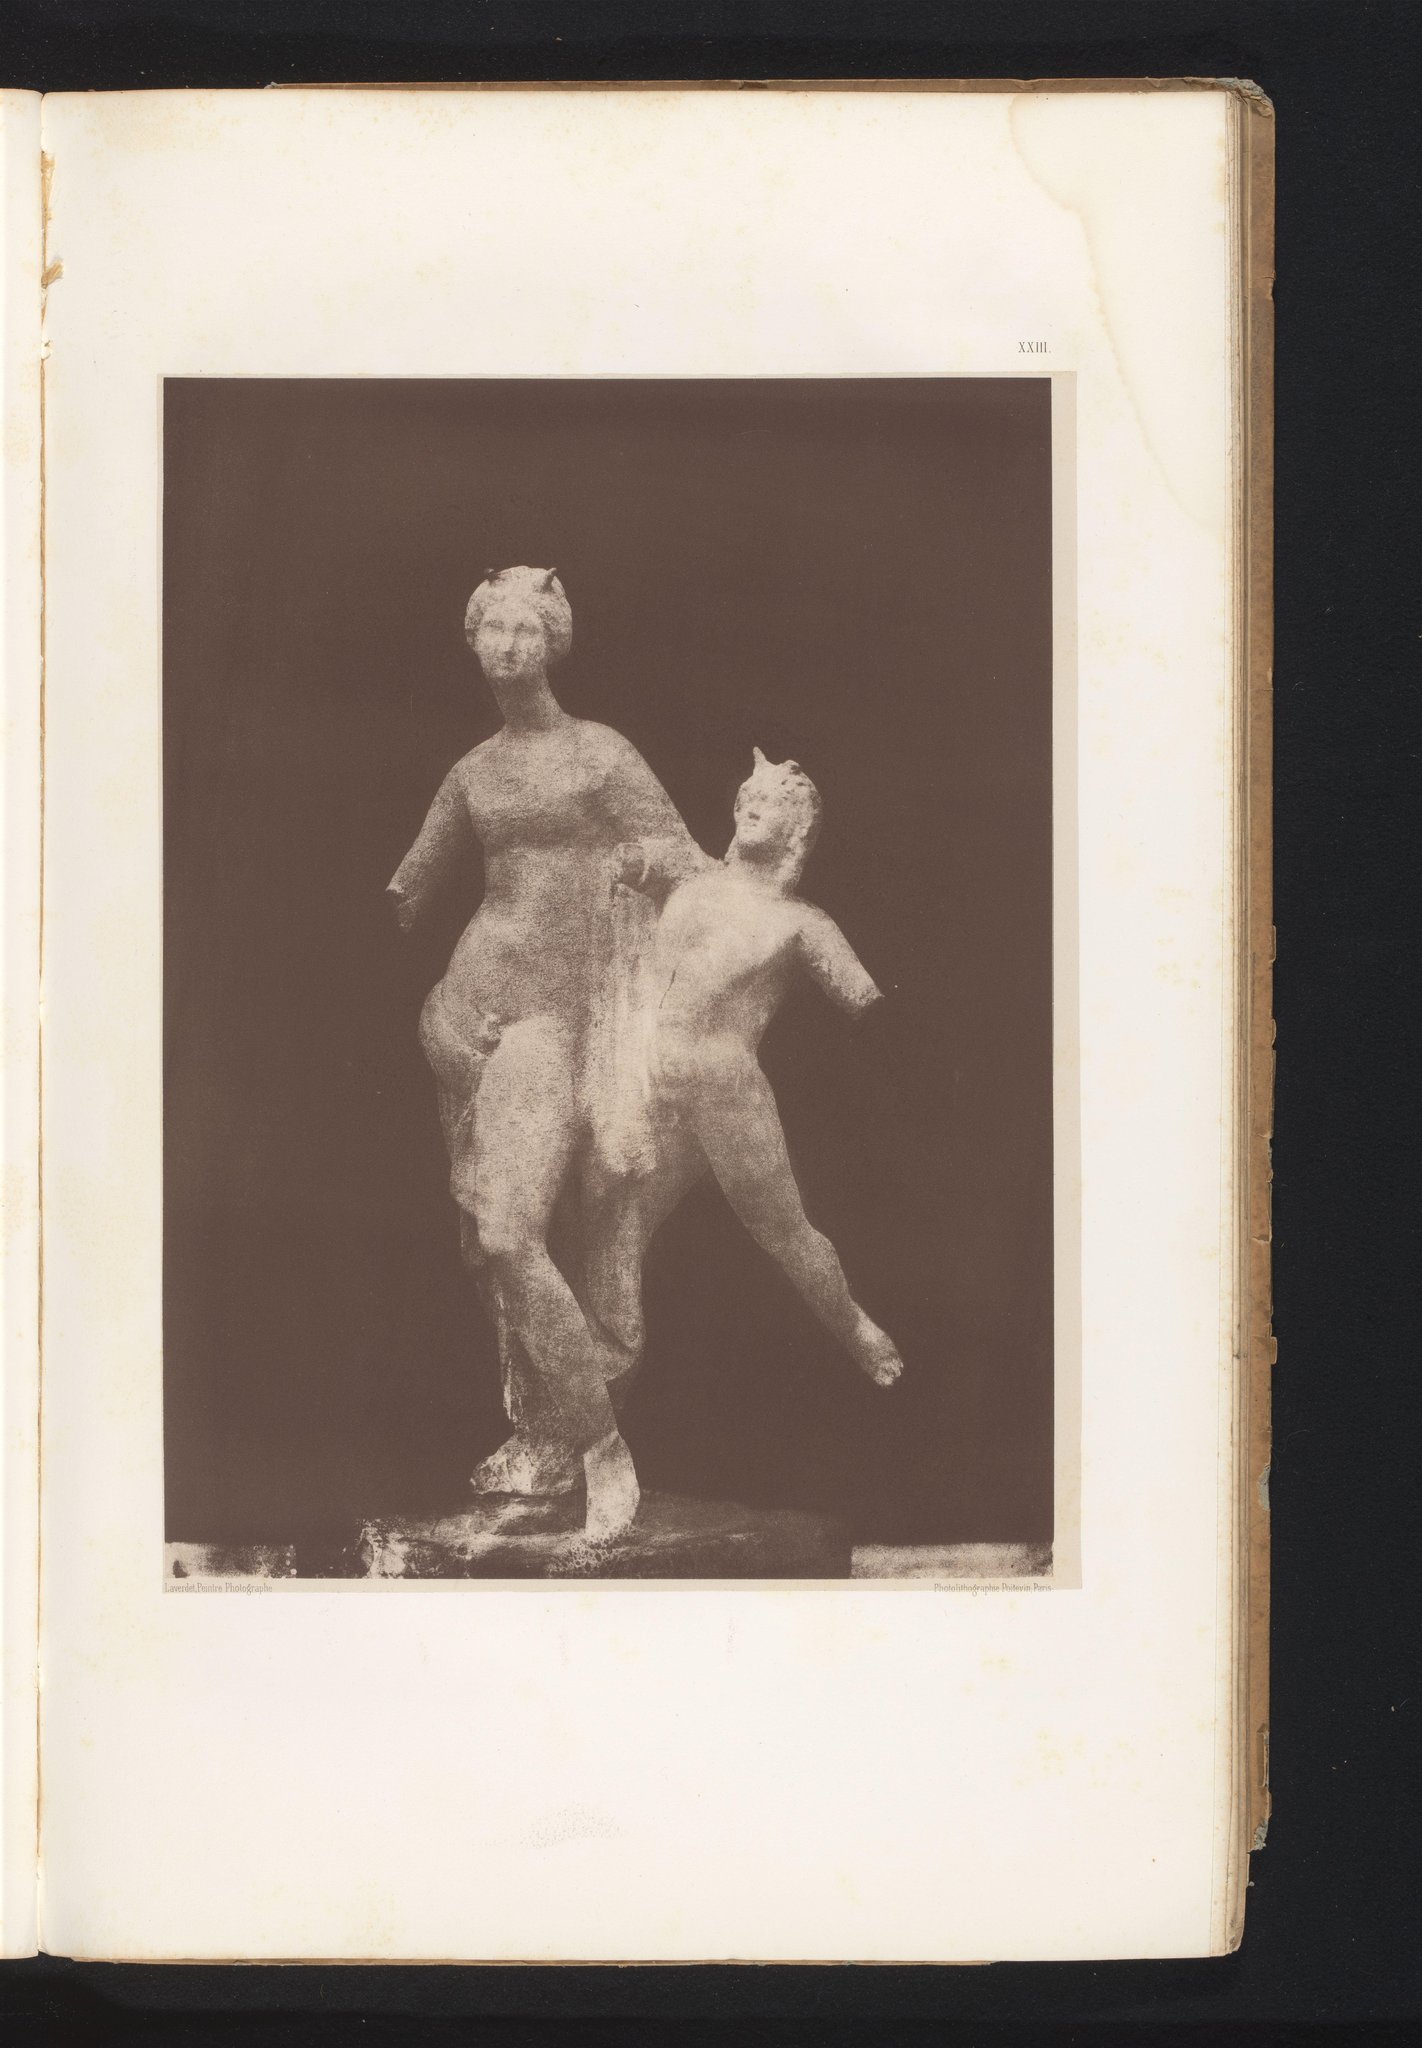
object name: page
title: Terracotta sculptuur van een gehoornde Bacchus en een satyr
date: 1852-1857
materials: paper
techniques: photolithography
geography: paris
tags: (story of) bacchus (dionysus), liber, piece of sculpture, reproduction of a piece of sculpture (+ clay, sand, etc. ~ arts), satyr(s) (in general)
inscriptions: number: ‘XXIII.’